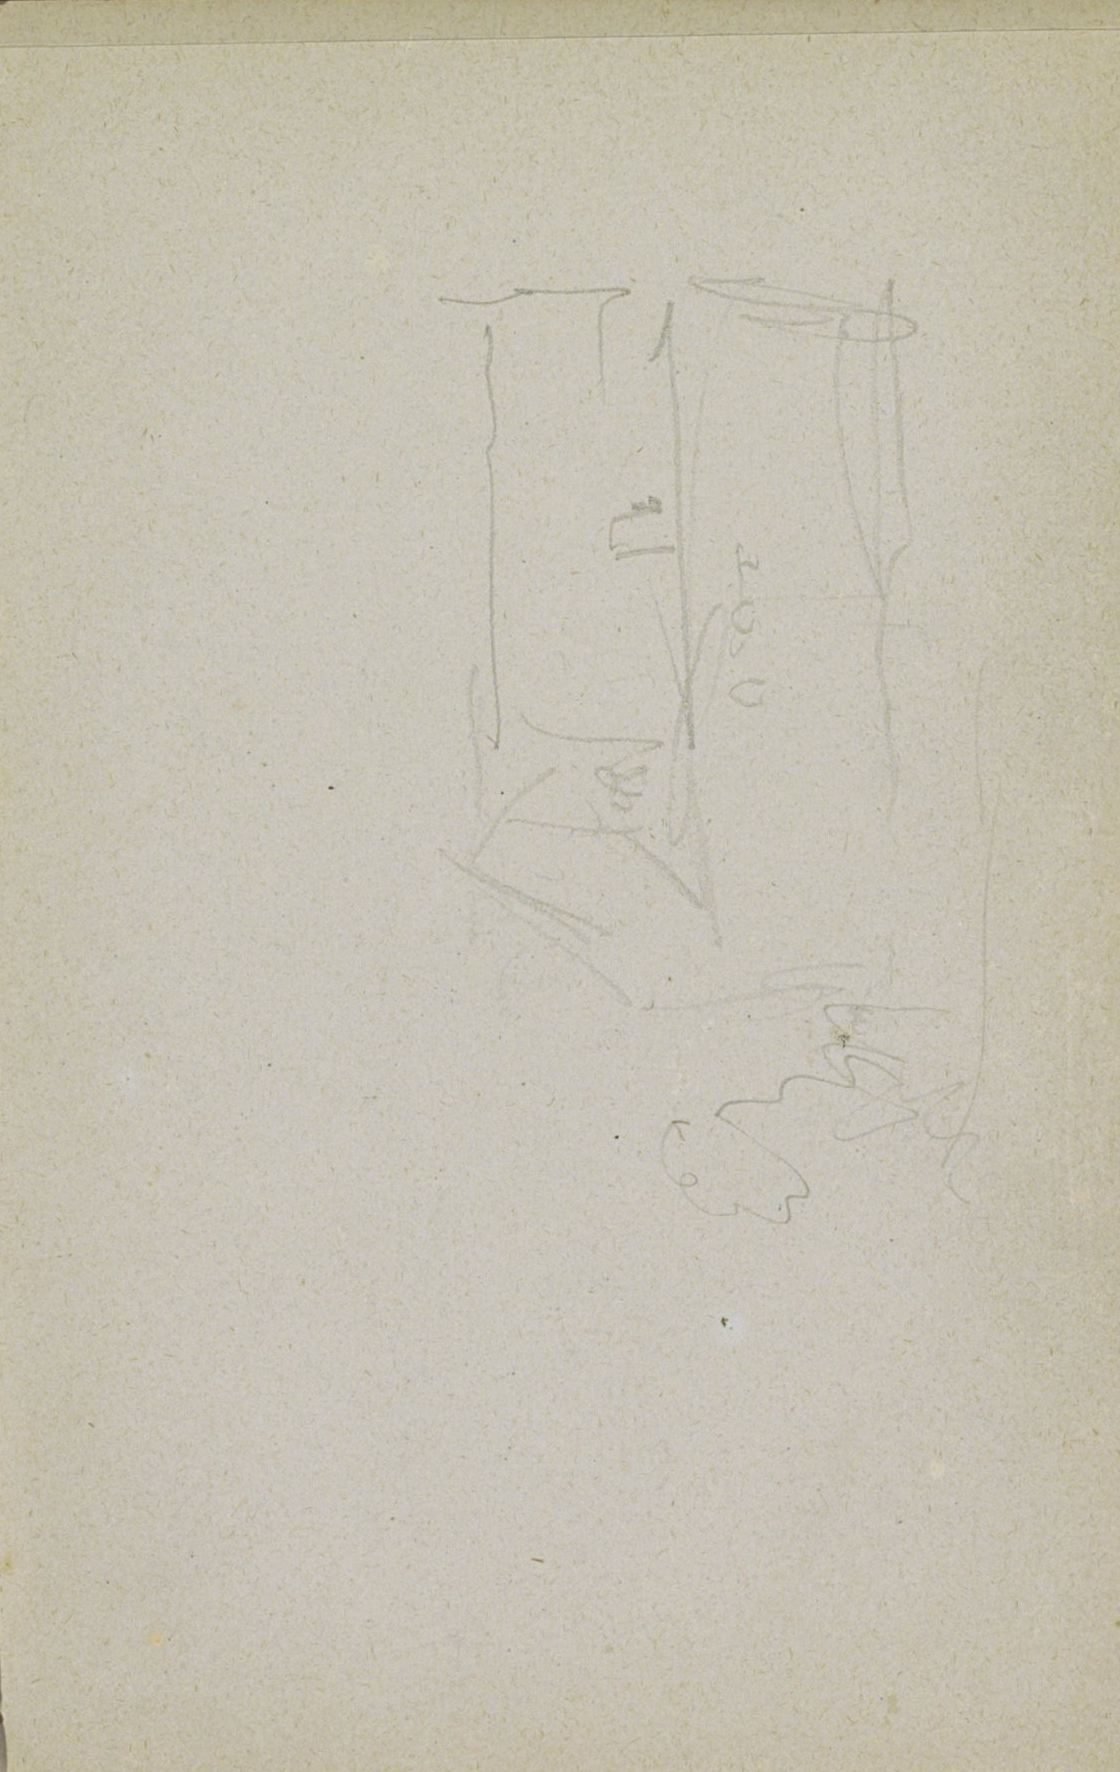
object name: sketchbook leaf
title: Gezicht op een gebouw bij een boom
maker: adrianus eversen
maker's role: draughtsman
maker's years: 1818-1897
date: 1828-1897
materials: paper, pencil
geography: netherlands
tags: trees, civic architecture; edifices; dwellings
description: Gezicht op een gebouw bij een boom. Blad 6 recto uit een schetsboek met 58 bladen.